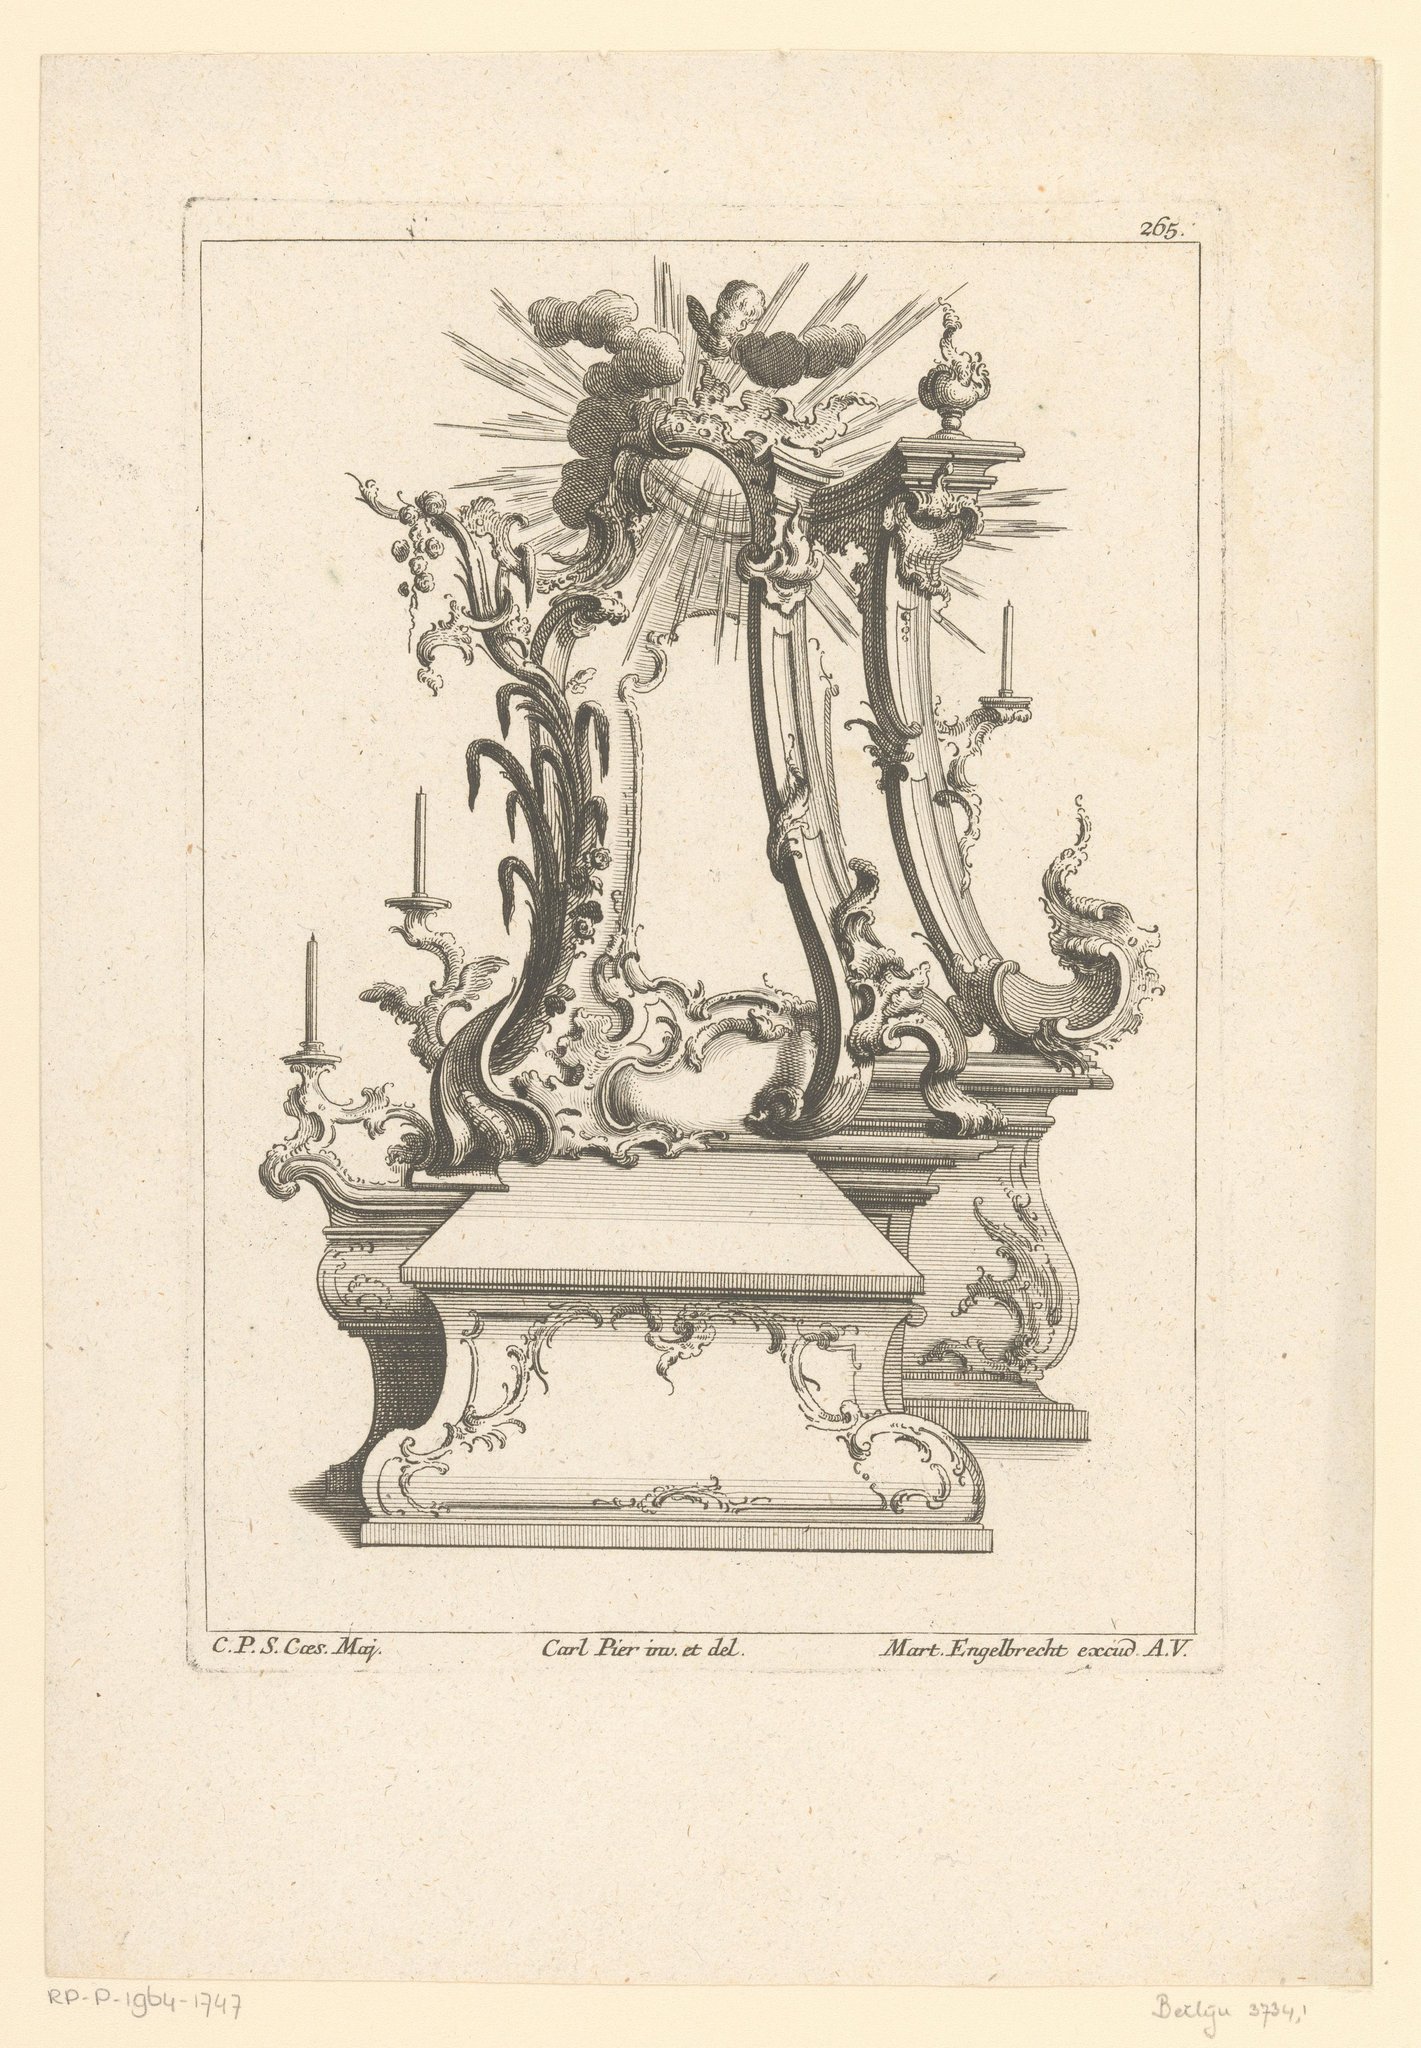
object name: ornament print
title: Altaren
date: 1740-1745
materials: paper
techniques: engraving, etching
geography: augsburg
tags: chandelier, candelabrum, rays of natural light, altar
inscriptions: collector's mark: Lugt 2228, collector's mark: Lugt 2760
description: Ontwerp voor een rocaille altaar met drie kandelaren. Boven wordt een engelenhoofd met vleugels omgeven door wolken en lichtstralen. Prentnummer 265.